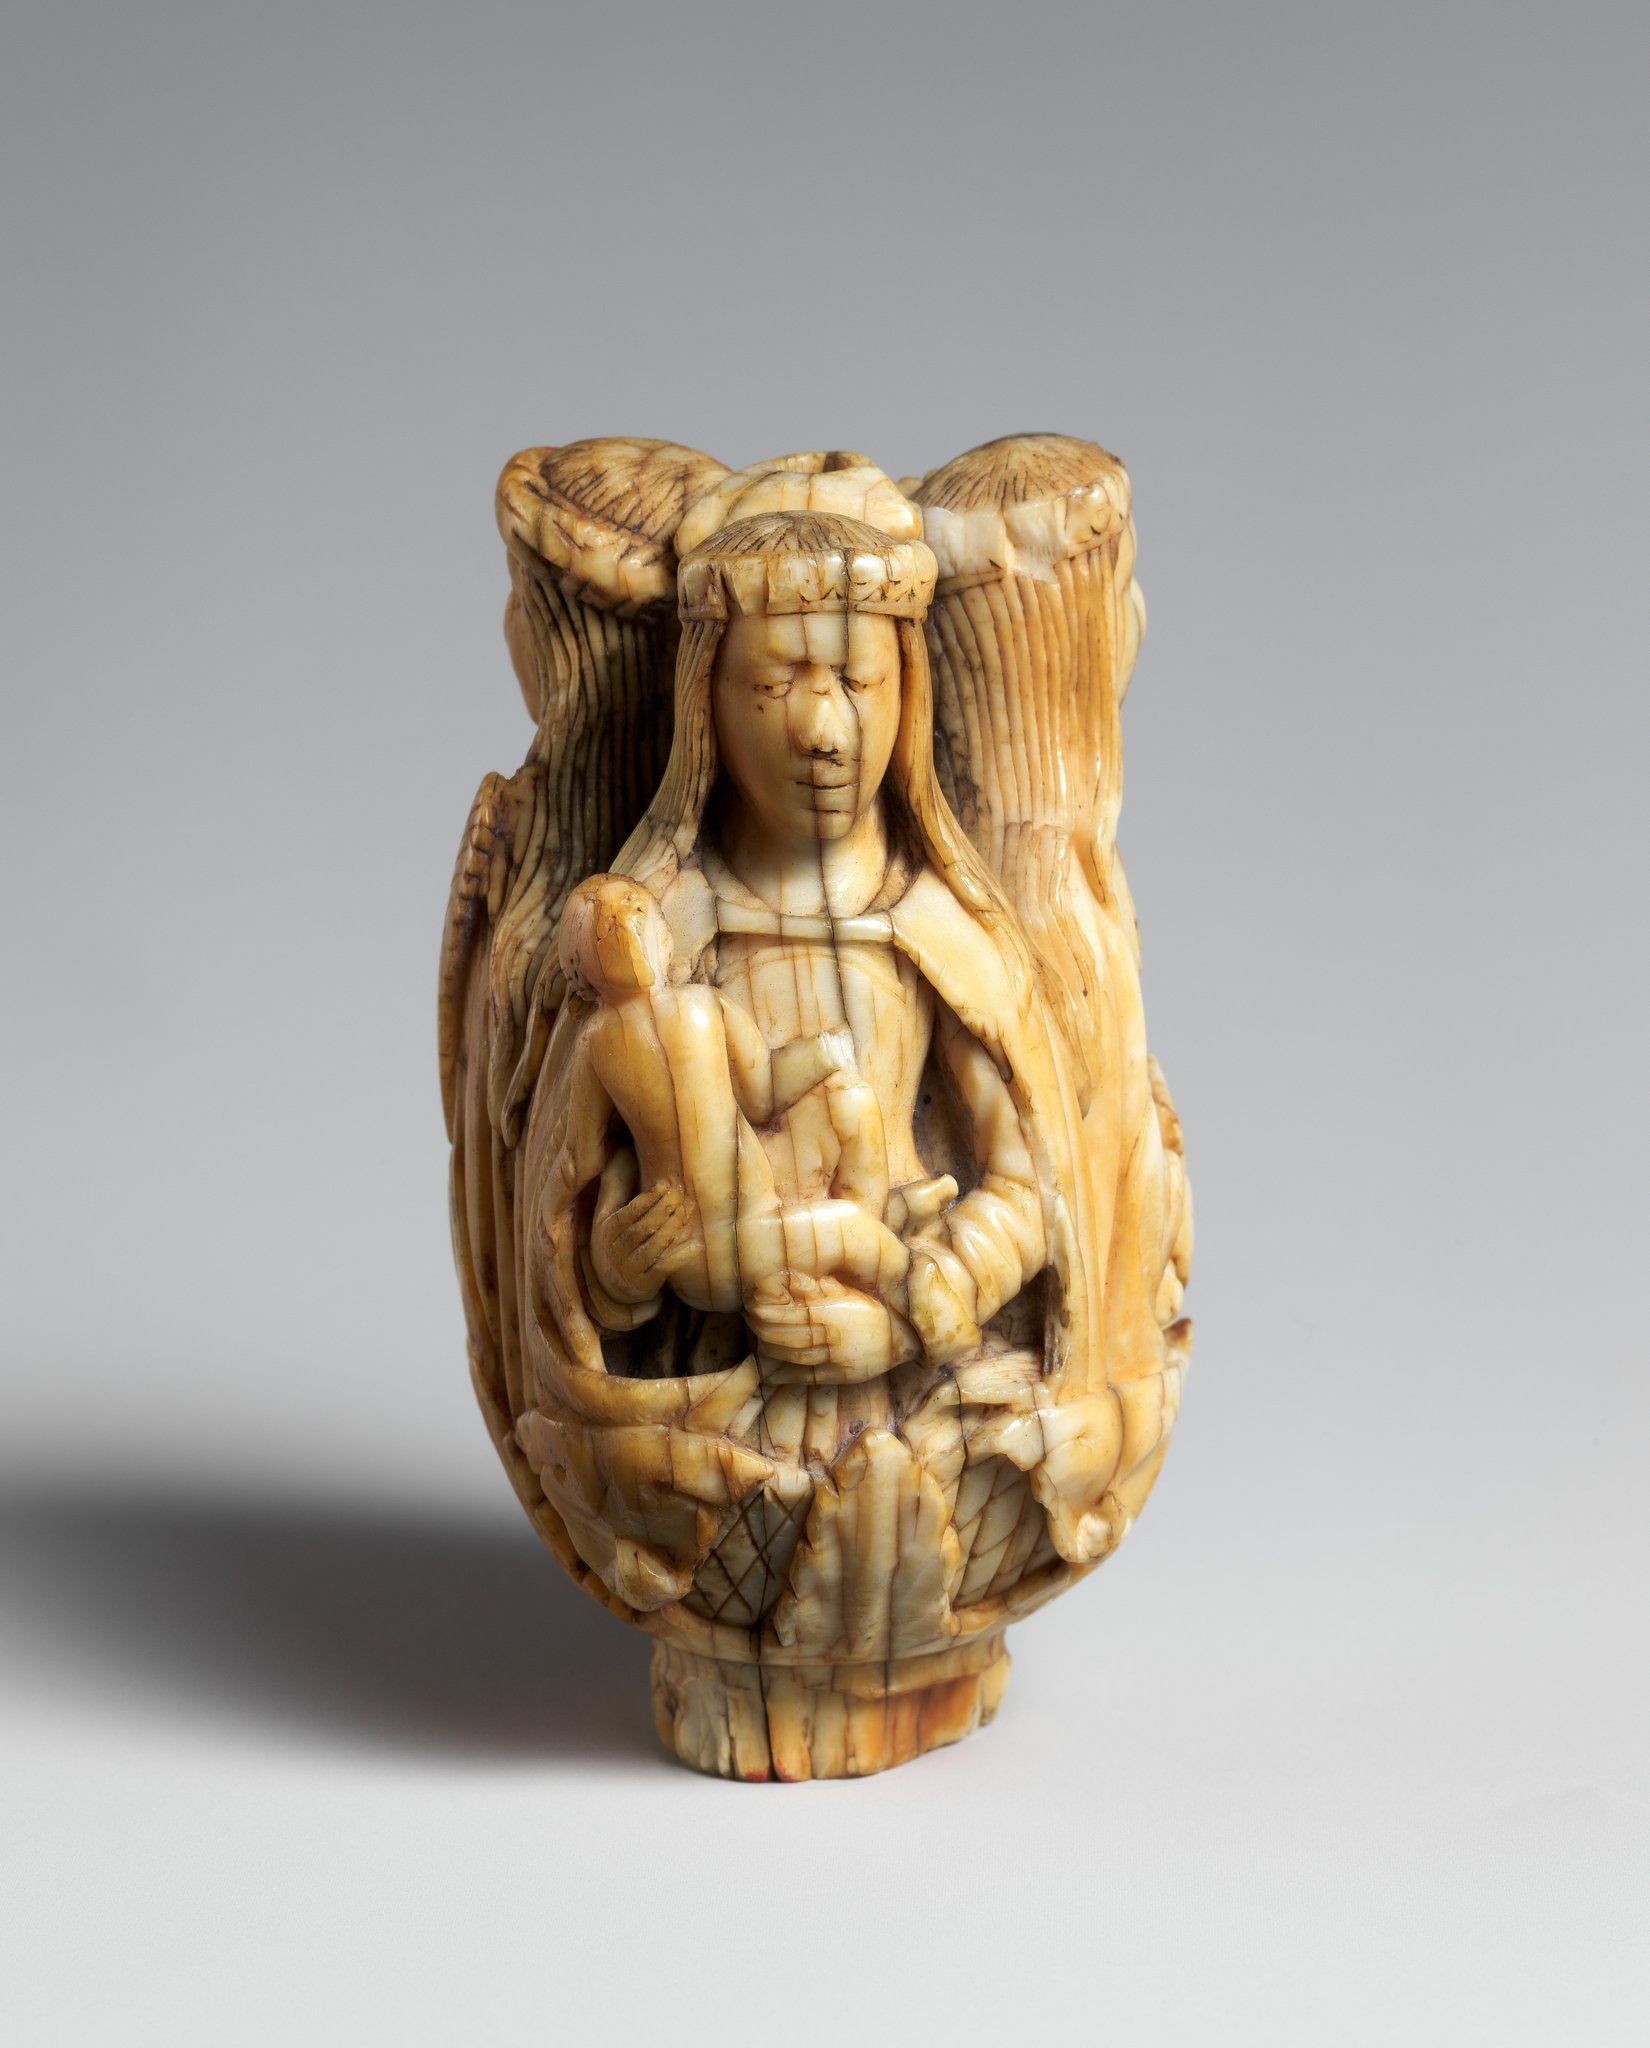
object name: rosary bead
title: Rosary Terminal Bead with the Virgin and Child, Saint Barbara, and Saint Catherine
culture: french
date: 1401-1500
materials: ivory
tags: madonna and child,saint catherine